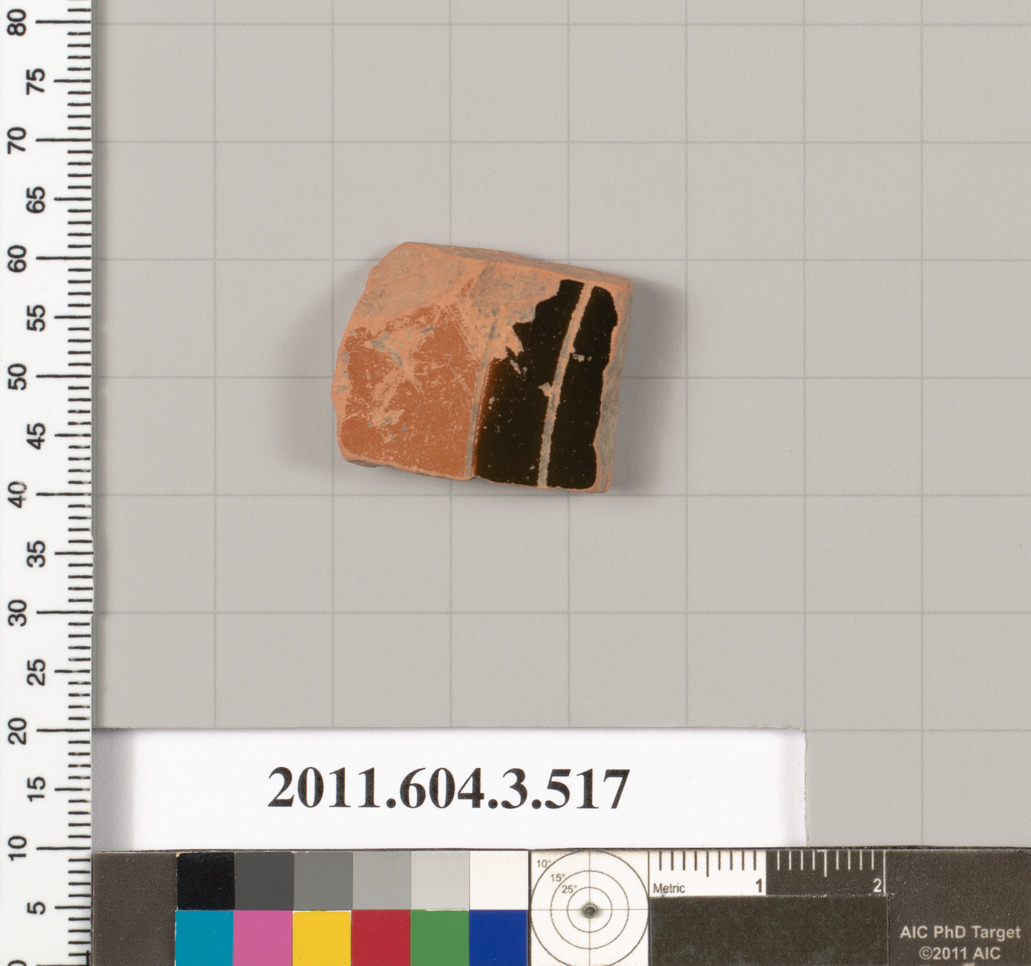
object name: column krater fragment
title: Terracotta fragment of a column-krater (bowl for mixing wine and water)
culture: greek, attic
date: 525-501 BCE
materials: terracotta